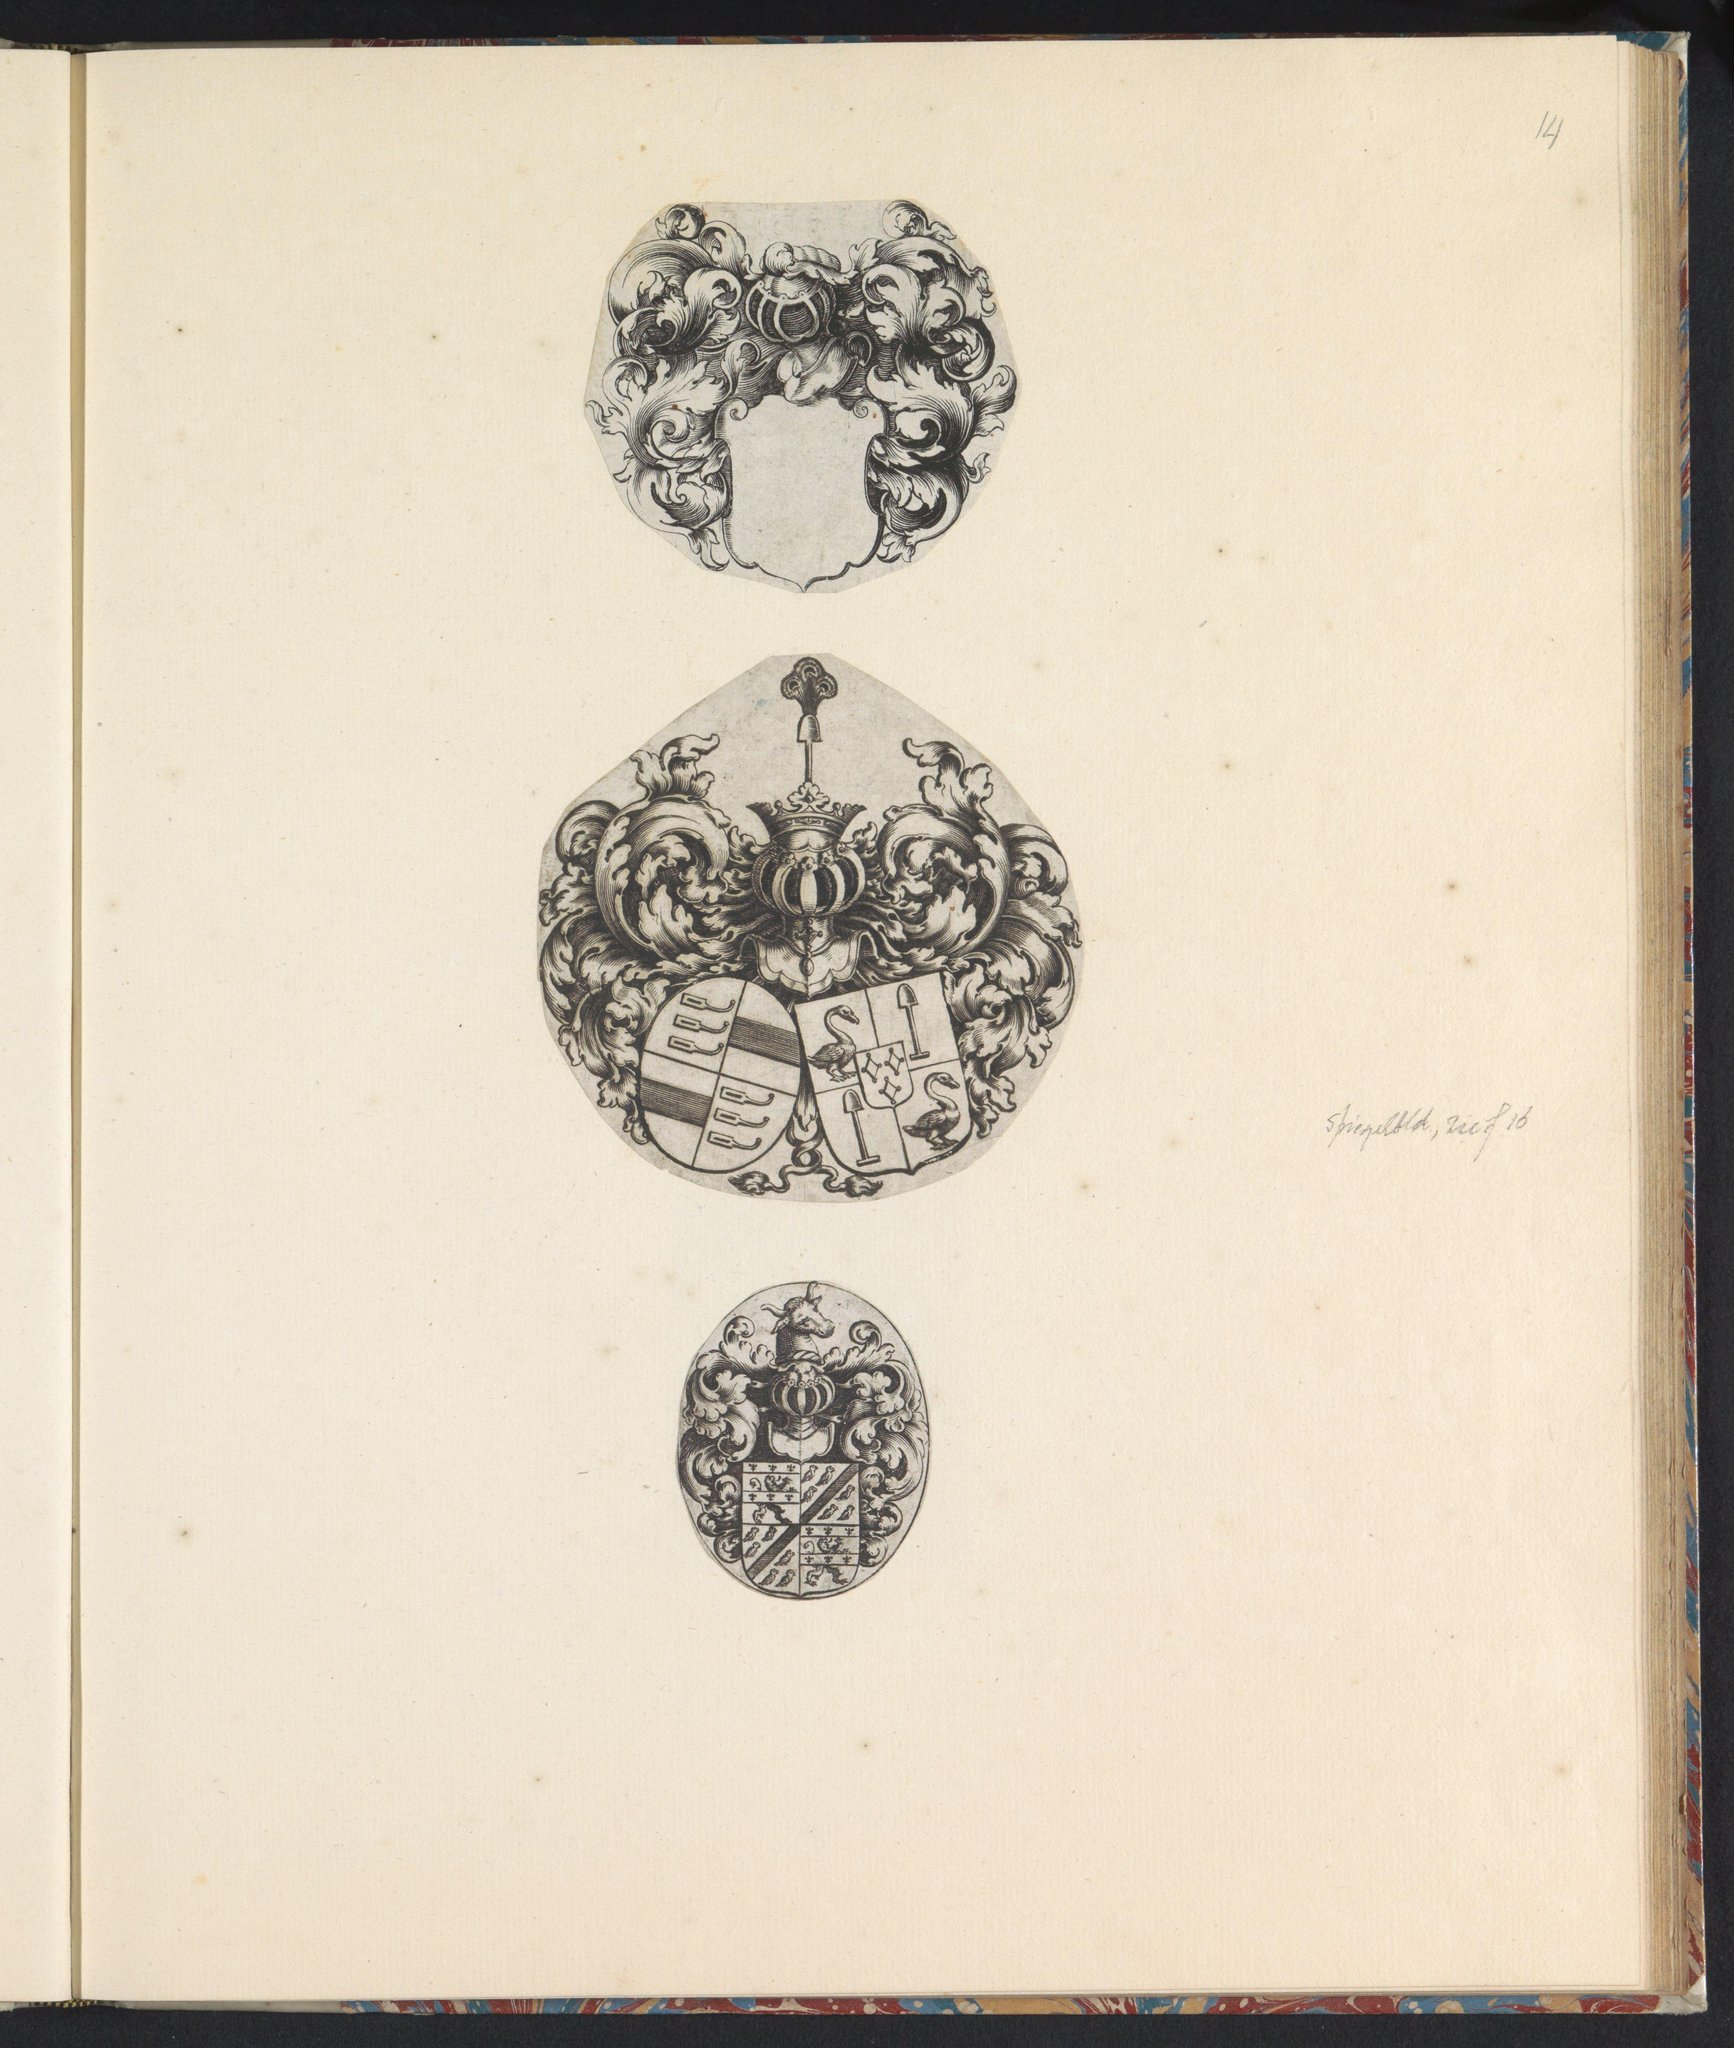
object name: album leaf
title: Drie wapens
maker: Anonymous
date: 1600-1699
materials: paper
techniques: engraving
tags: armorial bearing, heraldry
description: Drie voorstellingen op een albumblad. Boven een wapen met blanco schild. Daaronder een wapen gerelateerd aan de familie Bicker en De Graeff. Links een gevierendeeld schild met dwarsbalken en helmstokken. Rechts een gevierendeeld schild met twee zwanen en twee troffels. Als helmteken een schop met drie pauwenveren. Als onderste voorstelling een nog ongeïdentificeerd wapen met lelies, leeuwen, vogels en een os als helmteken. De prenten maken deel uit van een album.